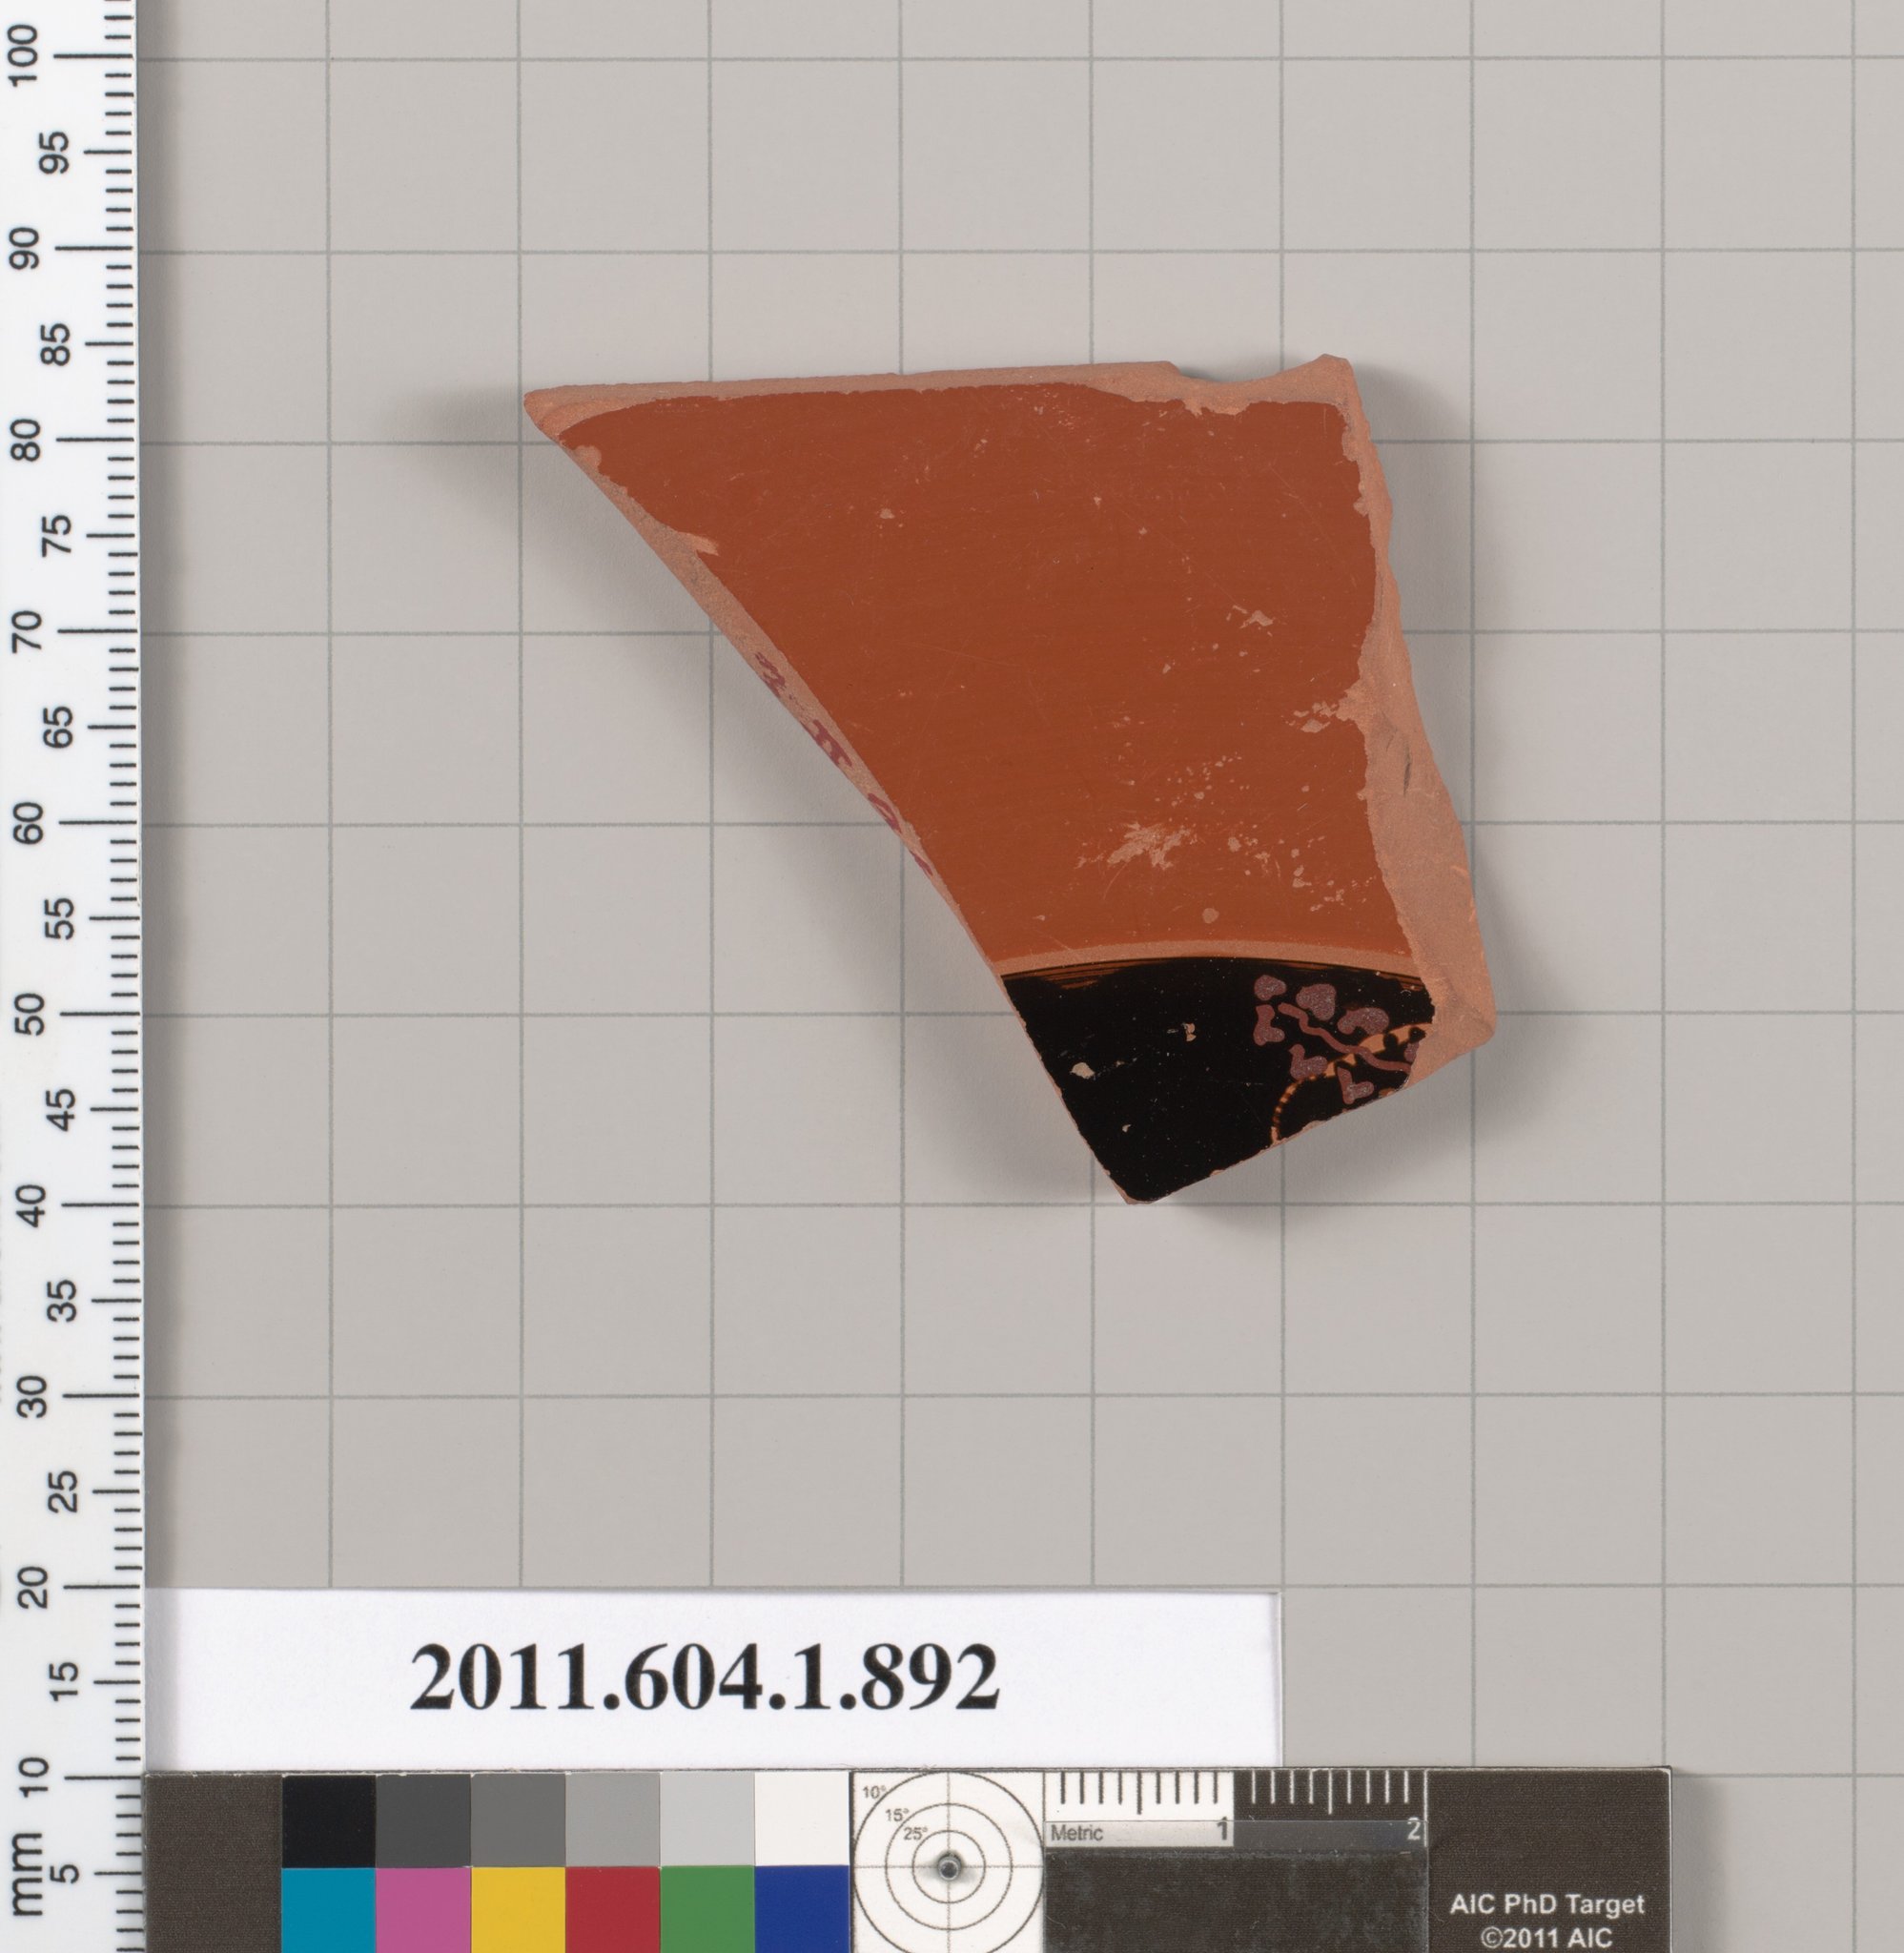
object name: kylix fragment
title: Terracotta fragment of a kylix (drinking cup)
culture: greek, attic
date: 534-501 BCE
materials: terracotta